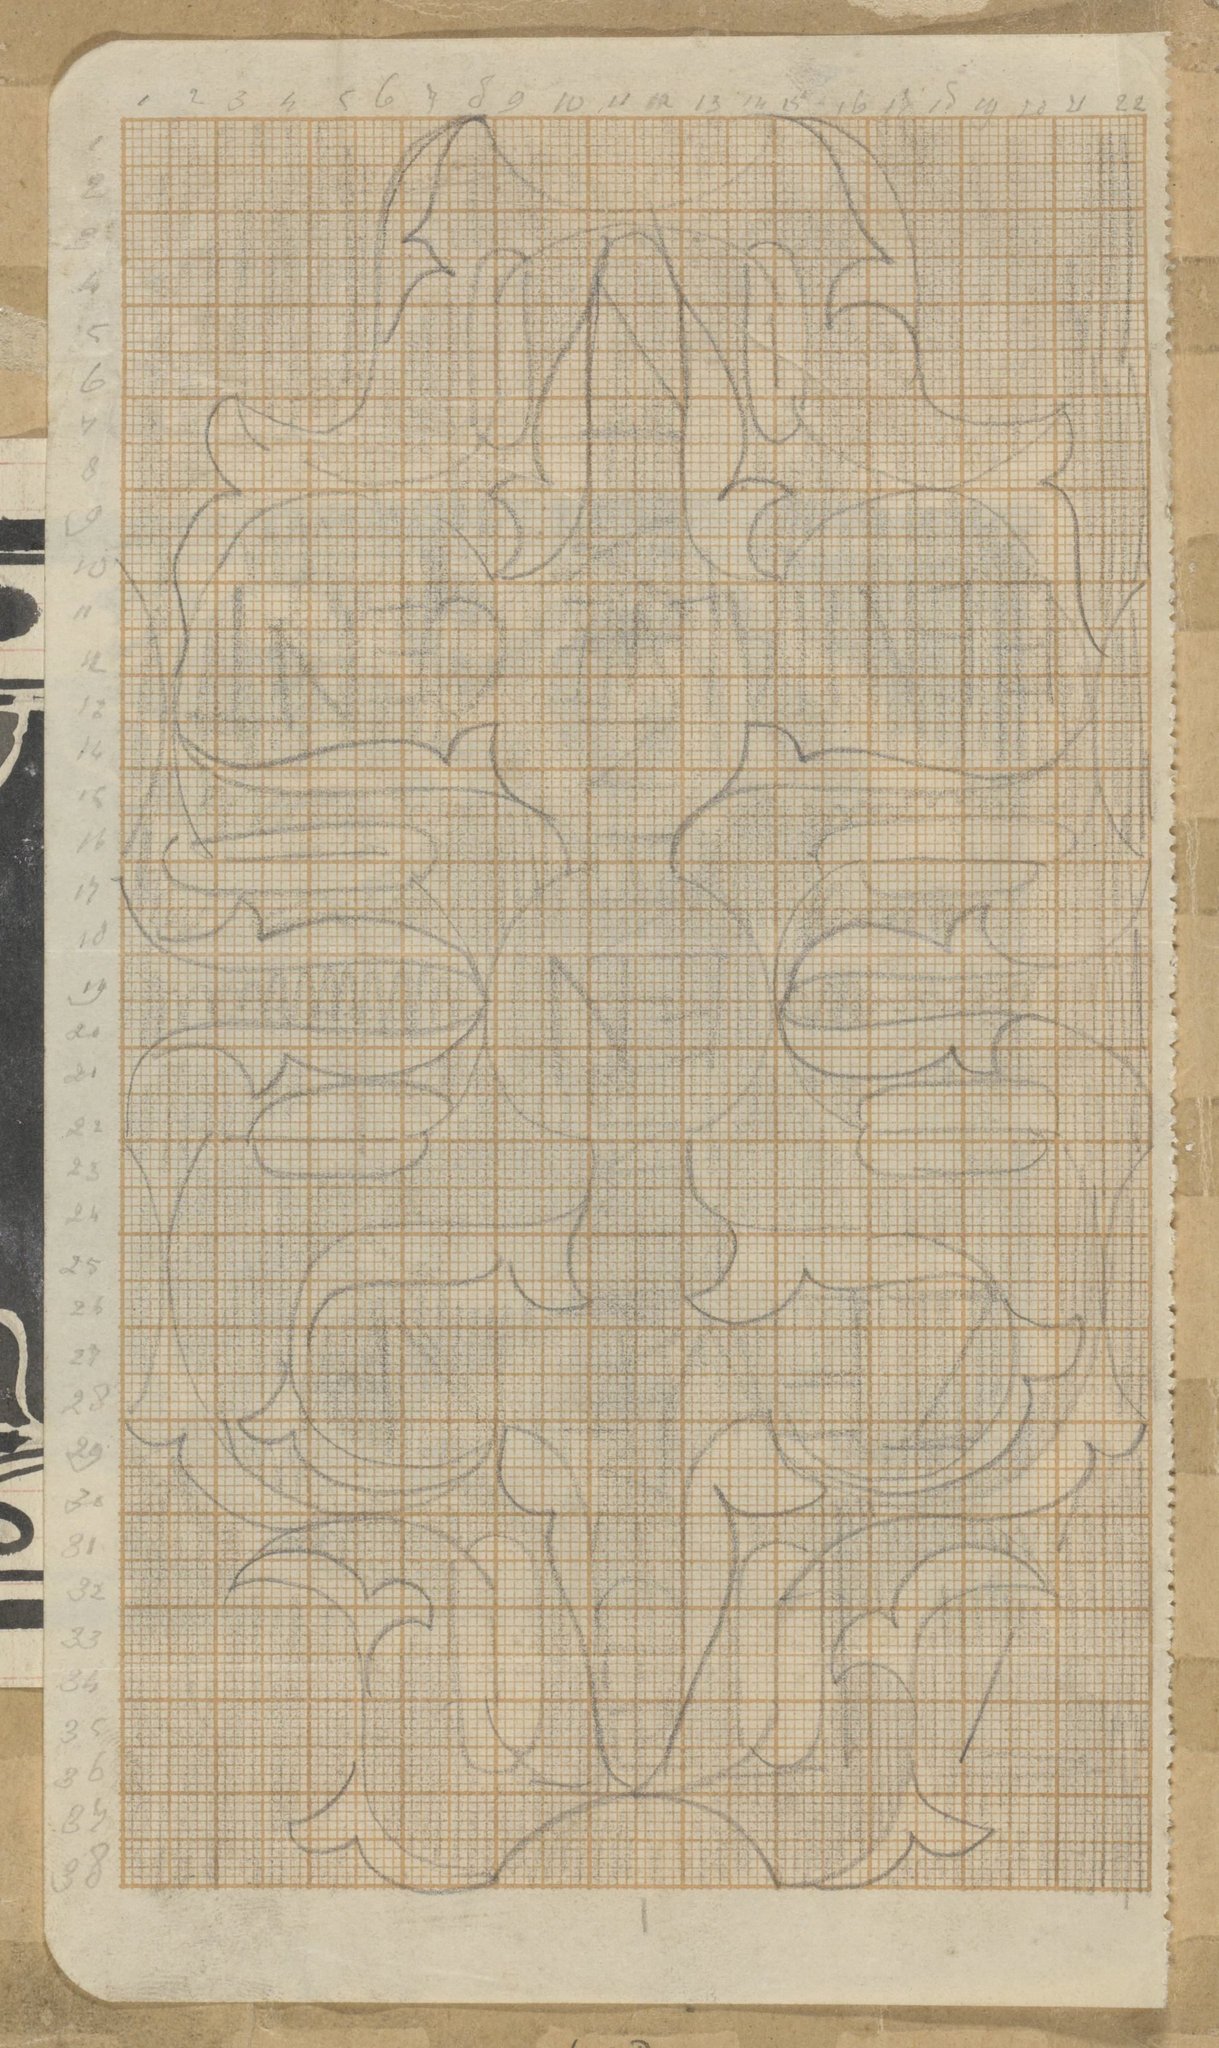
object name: drawing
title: Decoratief ontwerp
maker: carel adolph lion cachet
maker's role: draughtsman, print maker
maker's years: 1864-1945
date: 1874-1945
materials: pencil